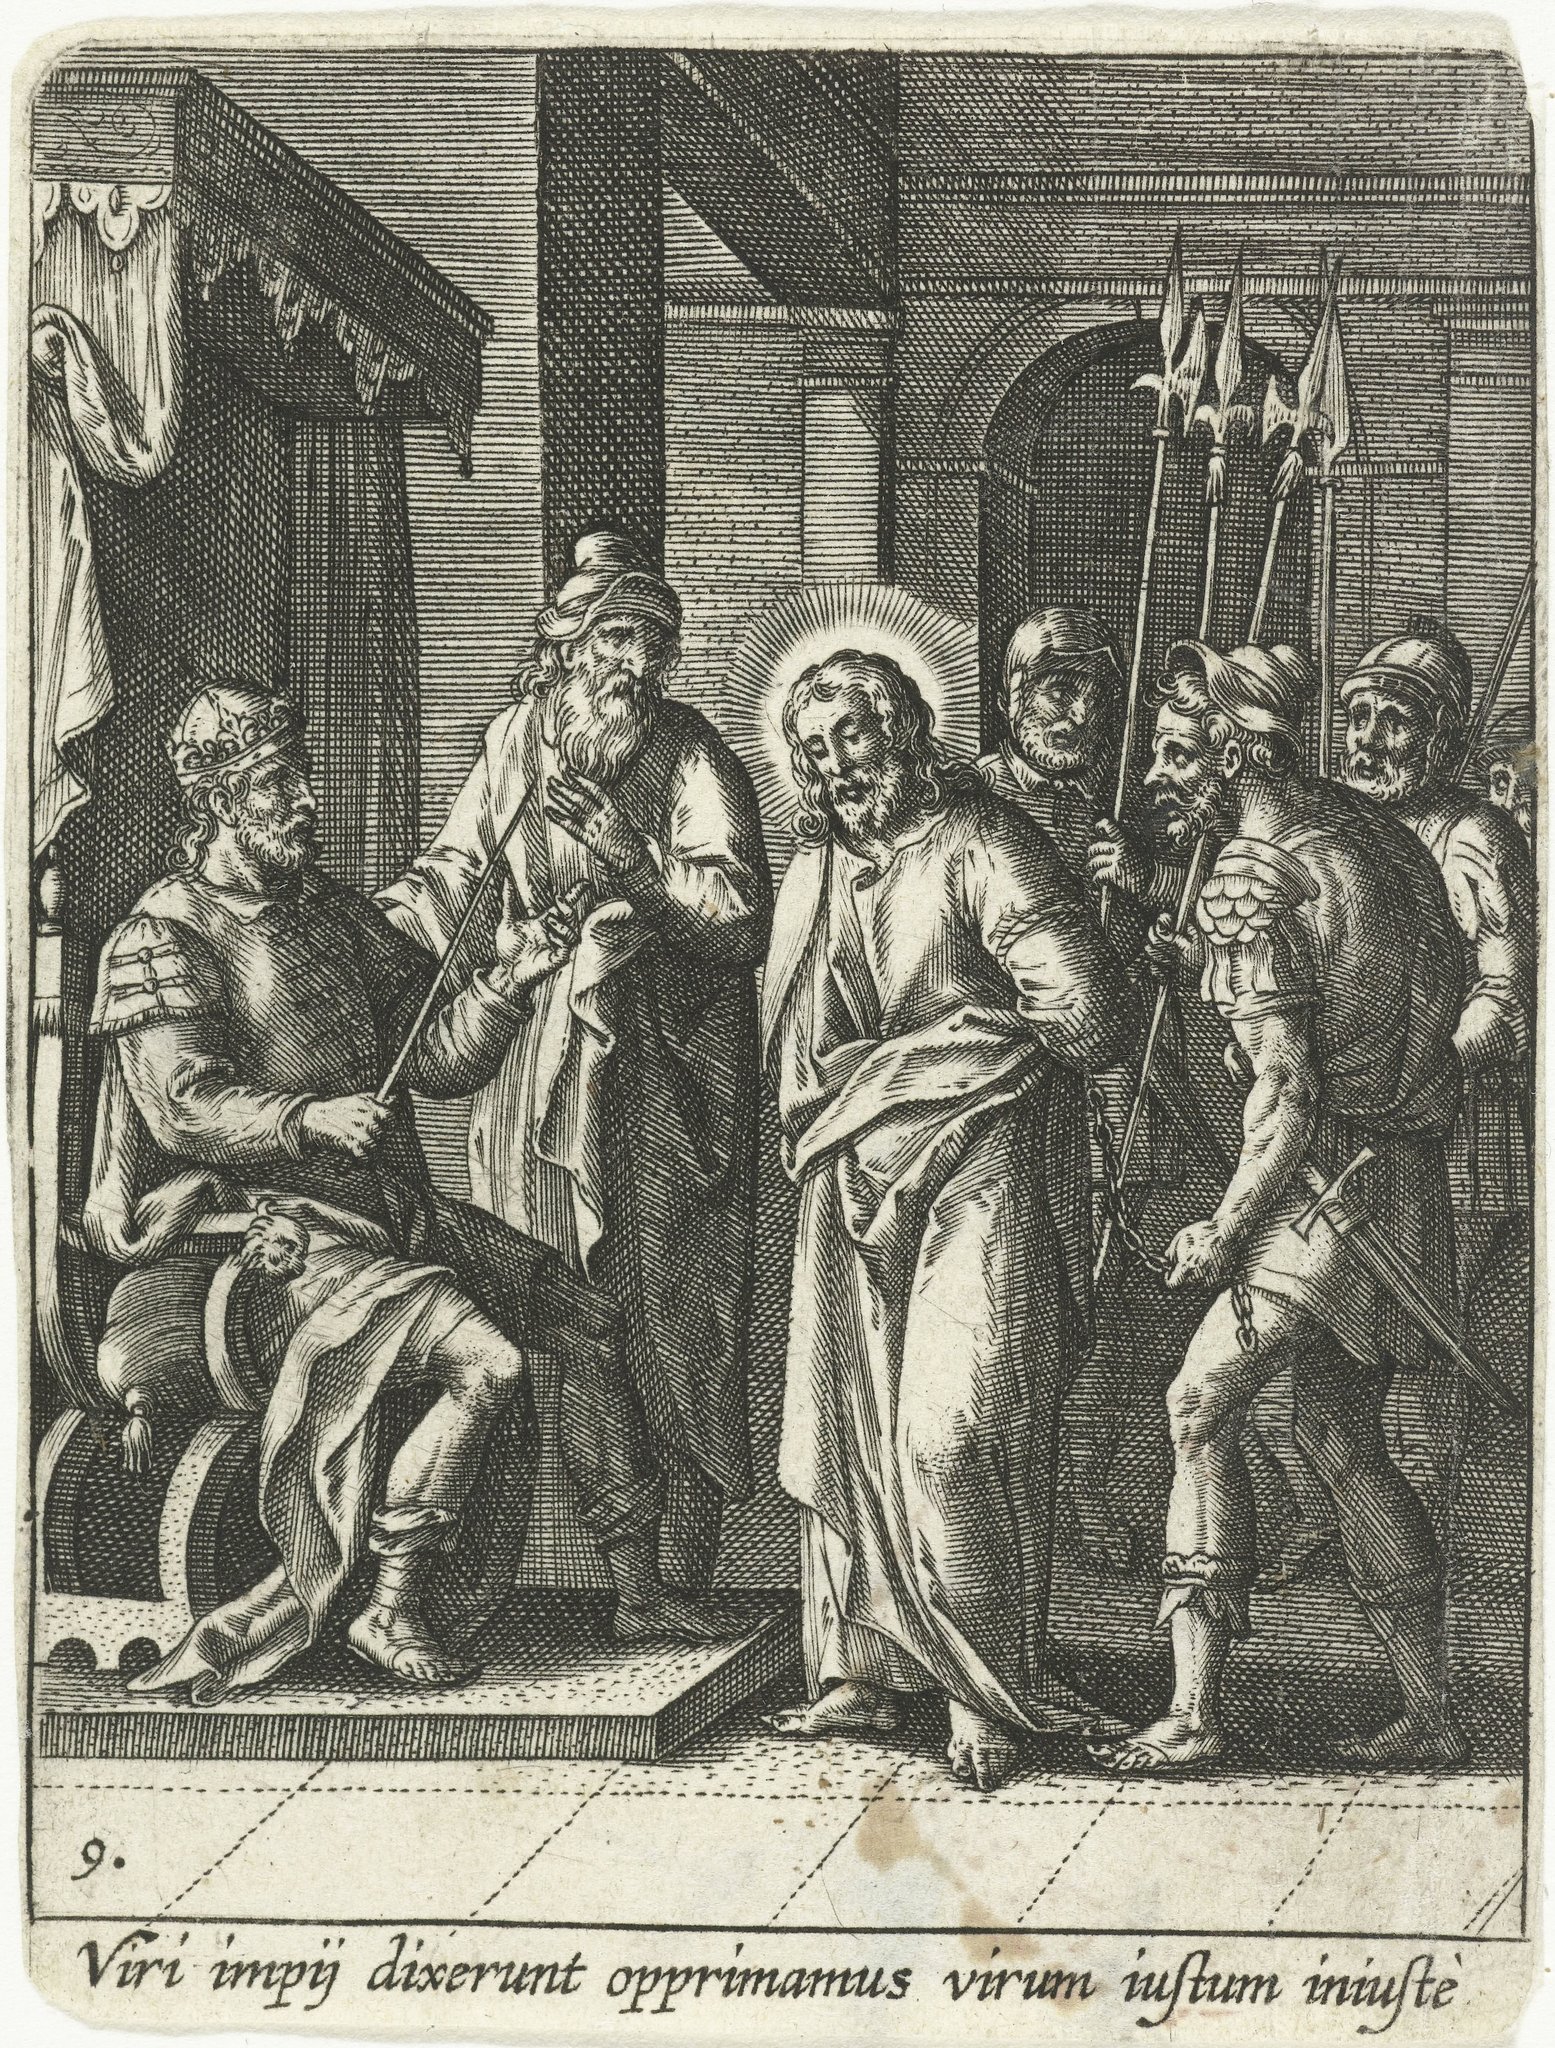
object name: print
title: Passie en wederopstanding van Christus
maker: adriaen collaert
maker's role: draughtsman, print maker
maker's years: 1560-1618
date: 1570-1618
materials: paper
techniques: engraving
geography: antwerp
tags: christ before king herod; sometimes a gorgeous robe is brought (luke 23:8-11)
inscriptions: collector's mark: Lugt 240, collector's mark: Lugt 2228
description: Christus wordt voor Herodes gebracht. De prent heeft een Latijns onderschrift